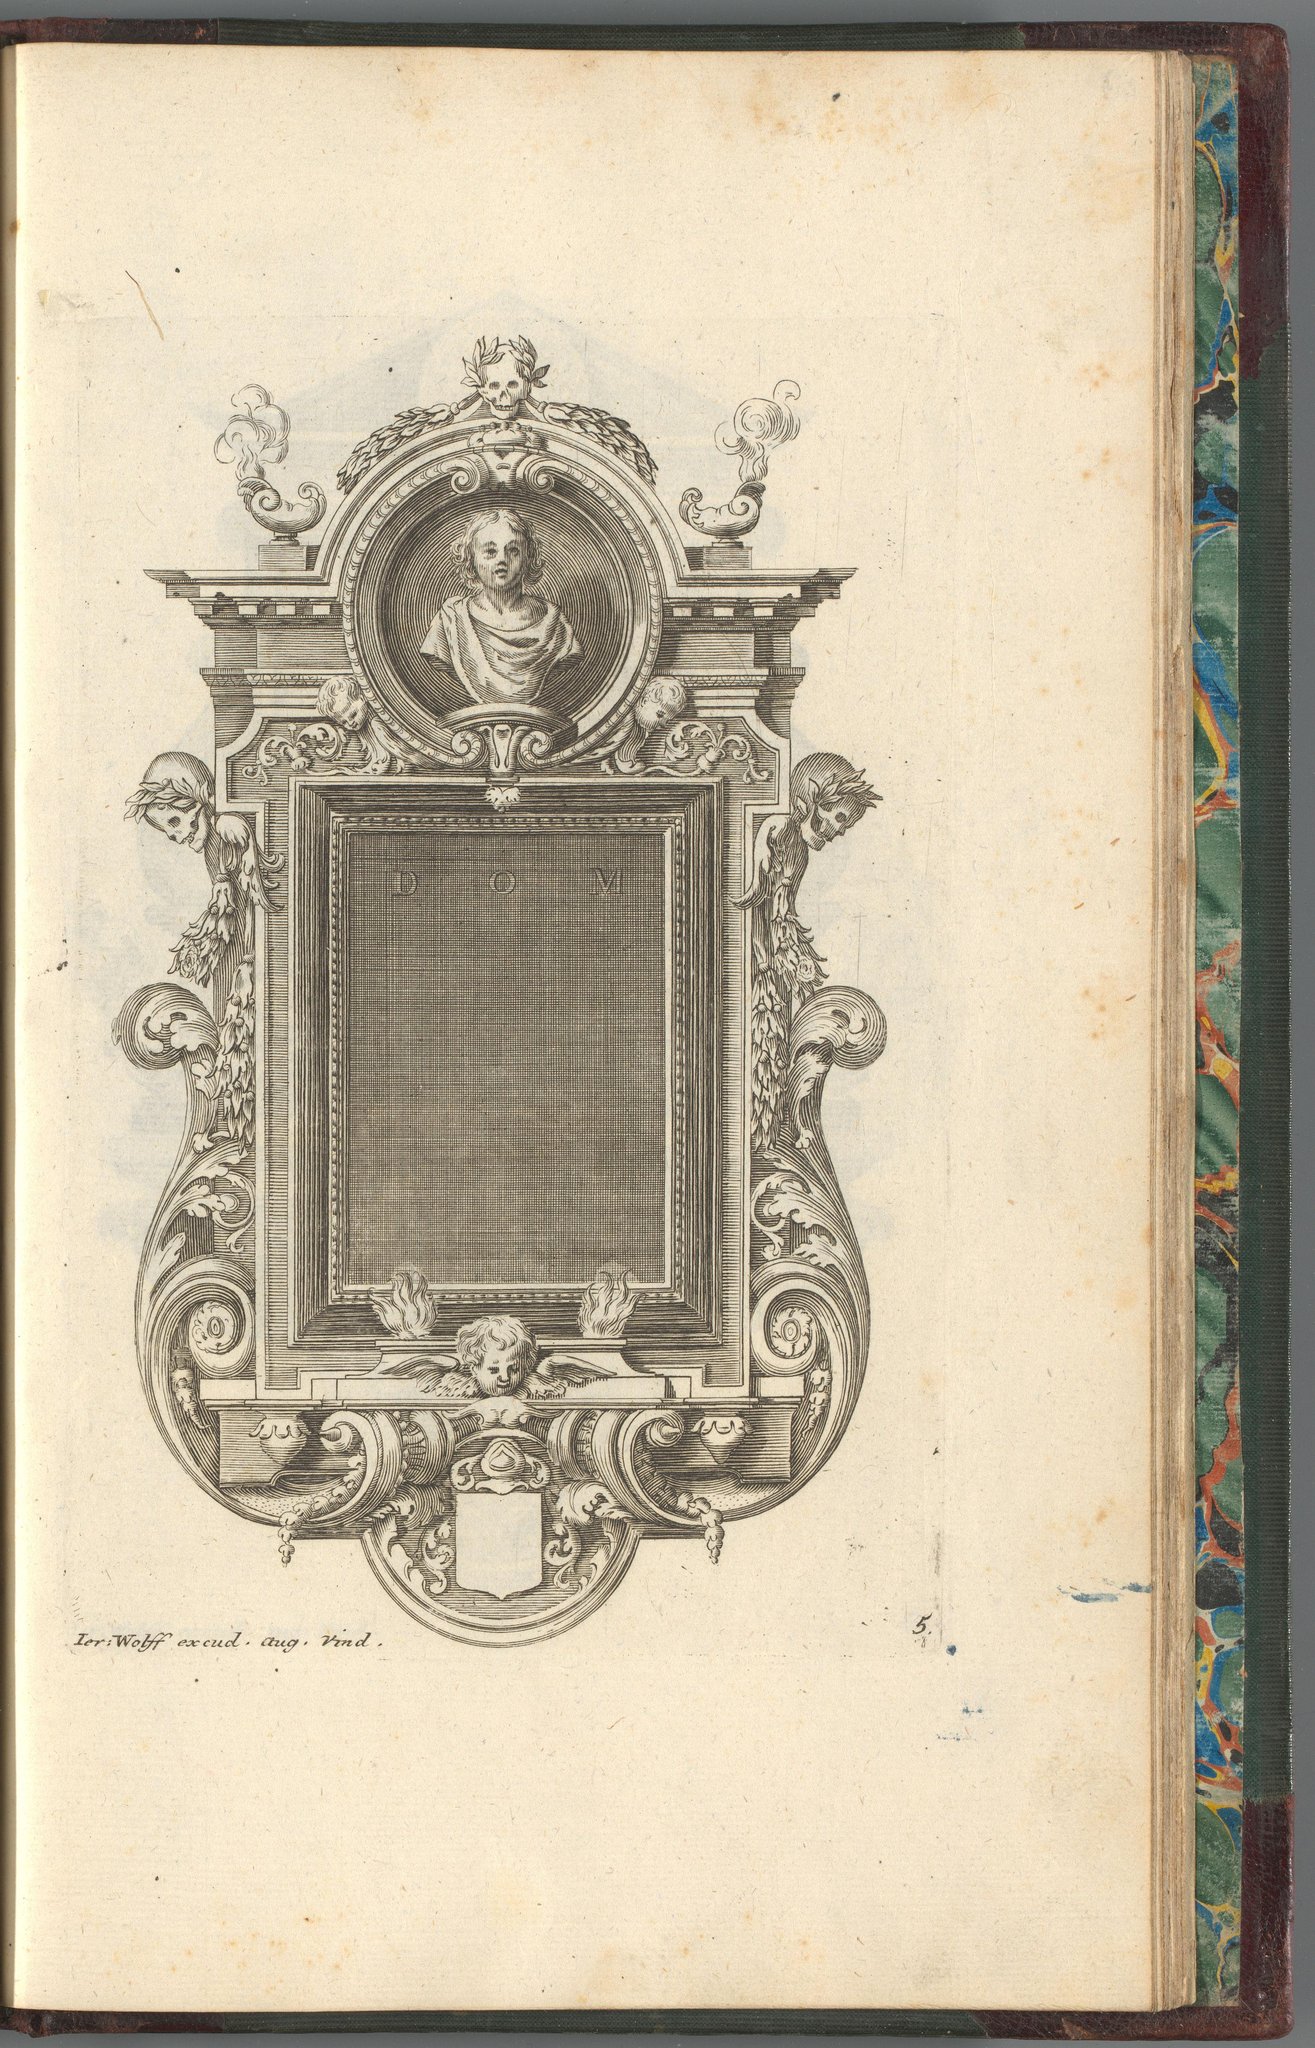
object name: ornament print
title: Epitaaf met buste van kind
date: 1686-1724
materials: paper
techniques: engraving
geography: amiens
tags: ornaments ~ art, epitaph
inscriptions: number: ‘5.’, signature: ‘Ier. Wolff excud. Aug. Vind.’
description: Een epitaaf met bovenaan in een ronde nis de buste van een kind, daaronder de letters DOM. Prent afkomstig uit een serie van zeven grafschriften. Prent maakt deel uit van een album. Gespiegelde kopie naar Frans origineel.